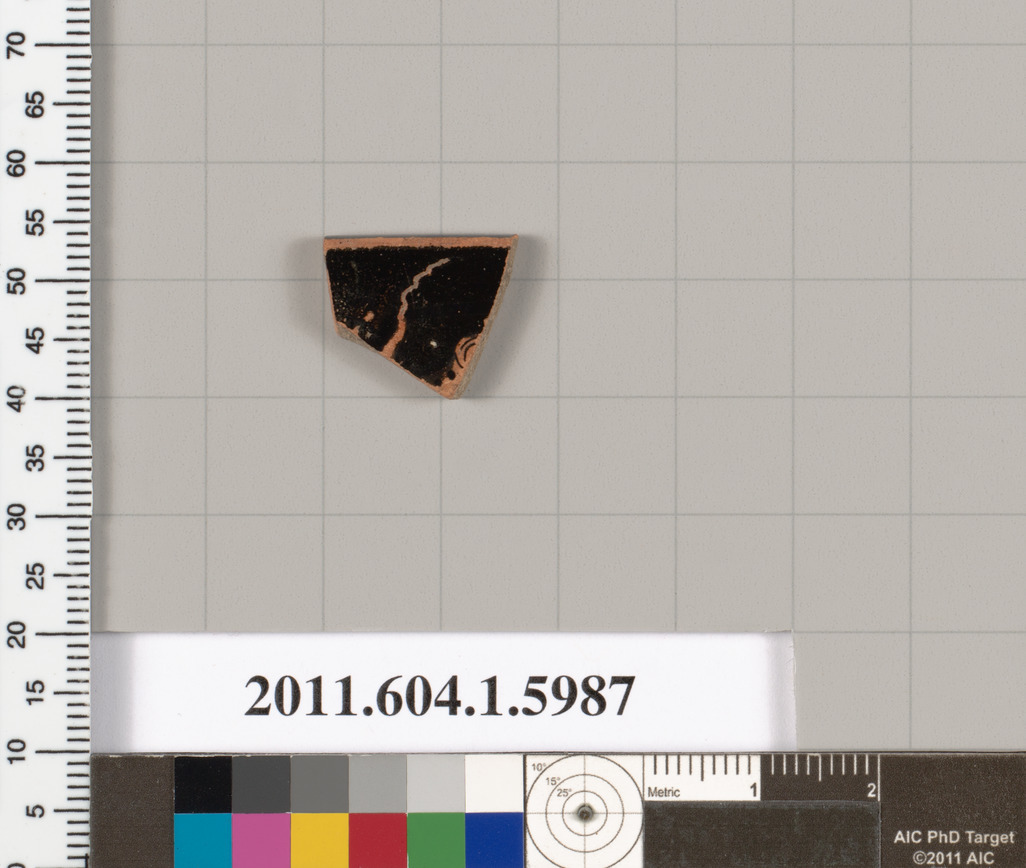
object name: kylix fragment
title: Terracotta rim fragment of a kylix (drinking cup)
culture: greek, attic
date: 510-500 BCE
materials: terracotta